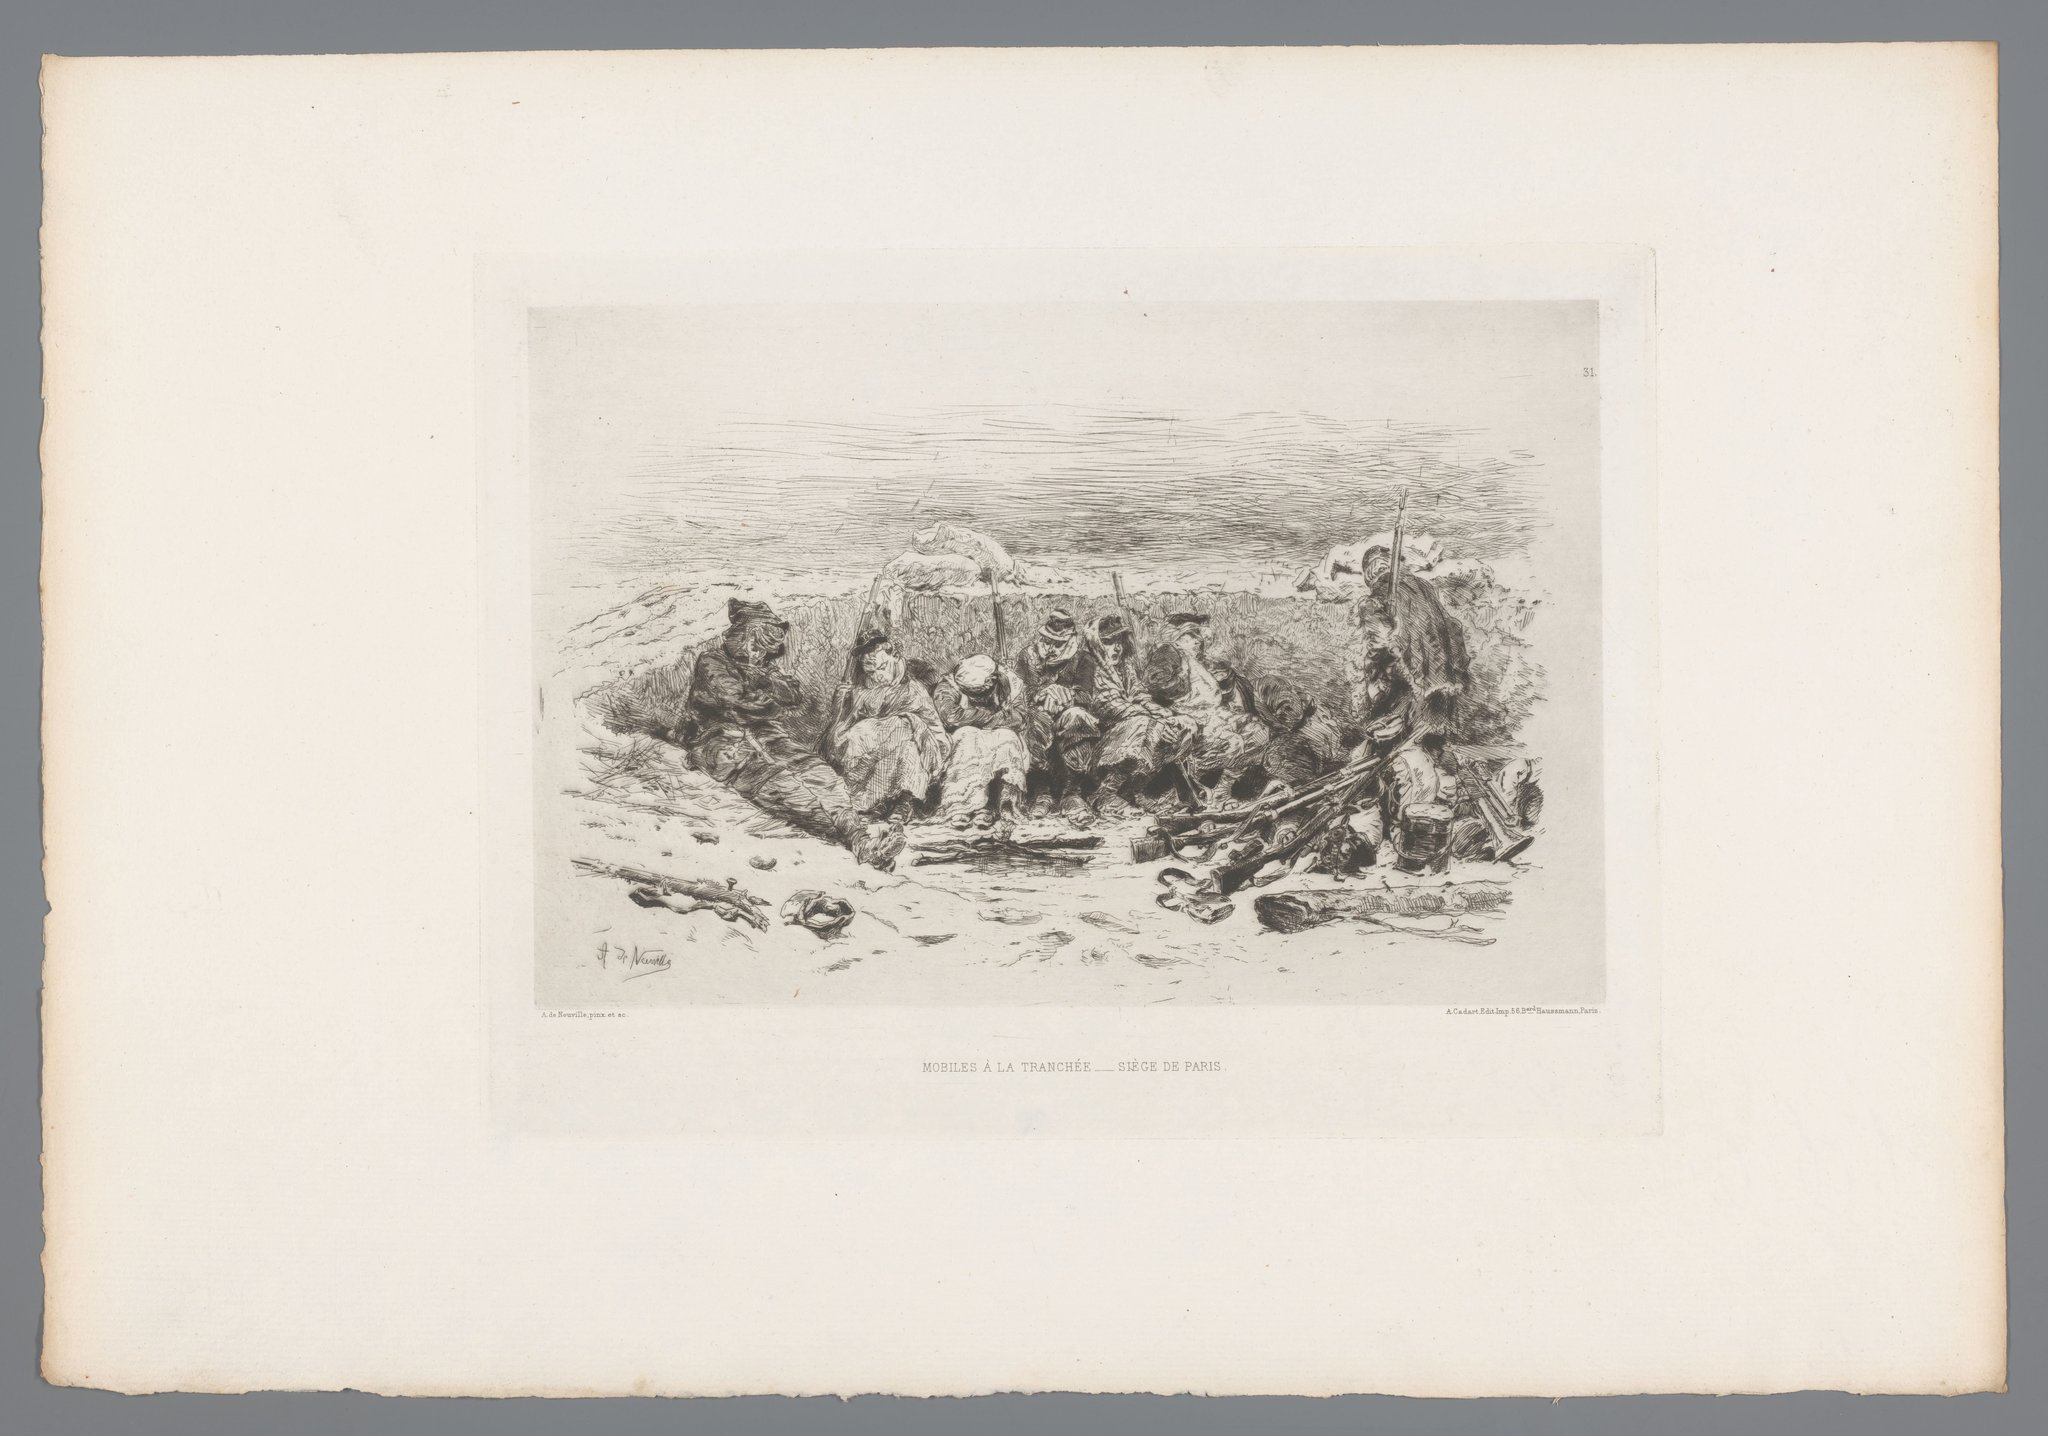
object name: print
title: Franse etsen uit 1875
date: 1875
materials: paper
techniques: drypoint, etching, intaglio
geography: paris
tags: trenches, paris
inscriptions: collector's mark: Lugt 2760, collector's mark: ‘AFE v S’, collector's mark: Lugt 2228